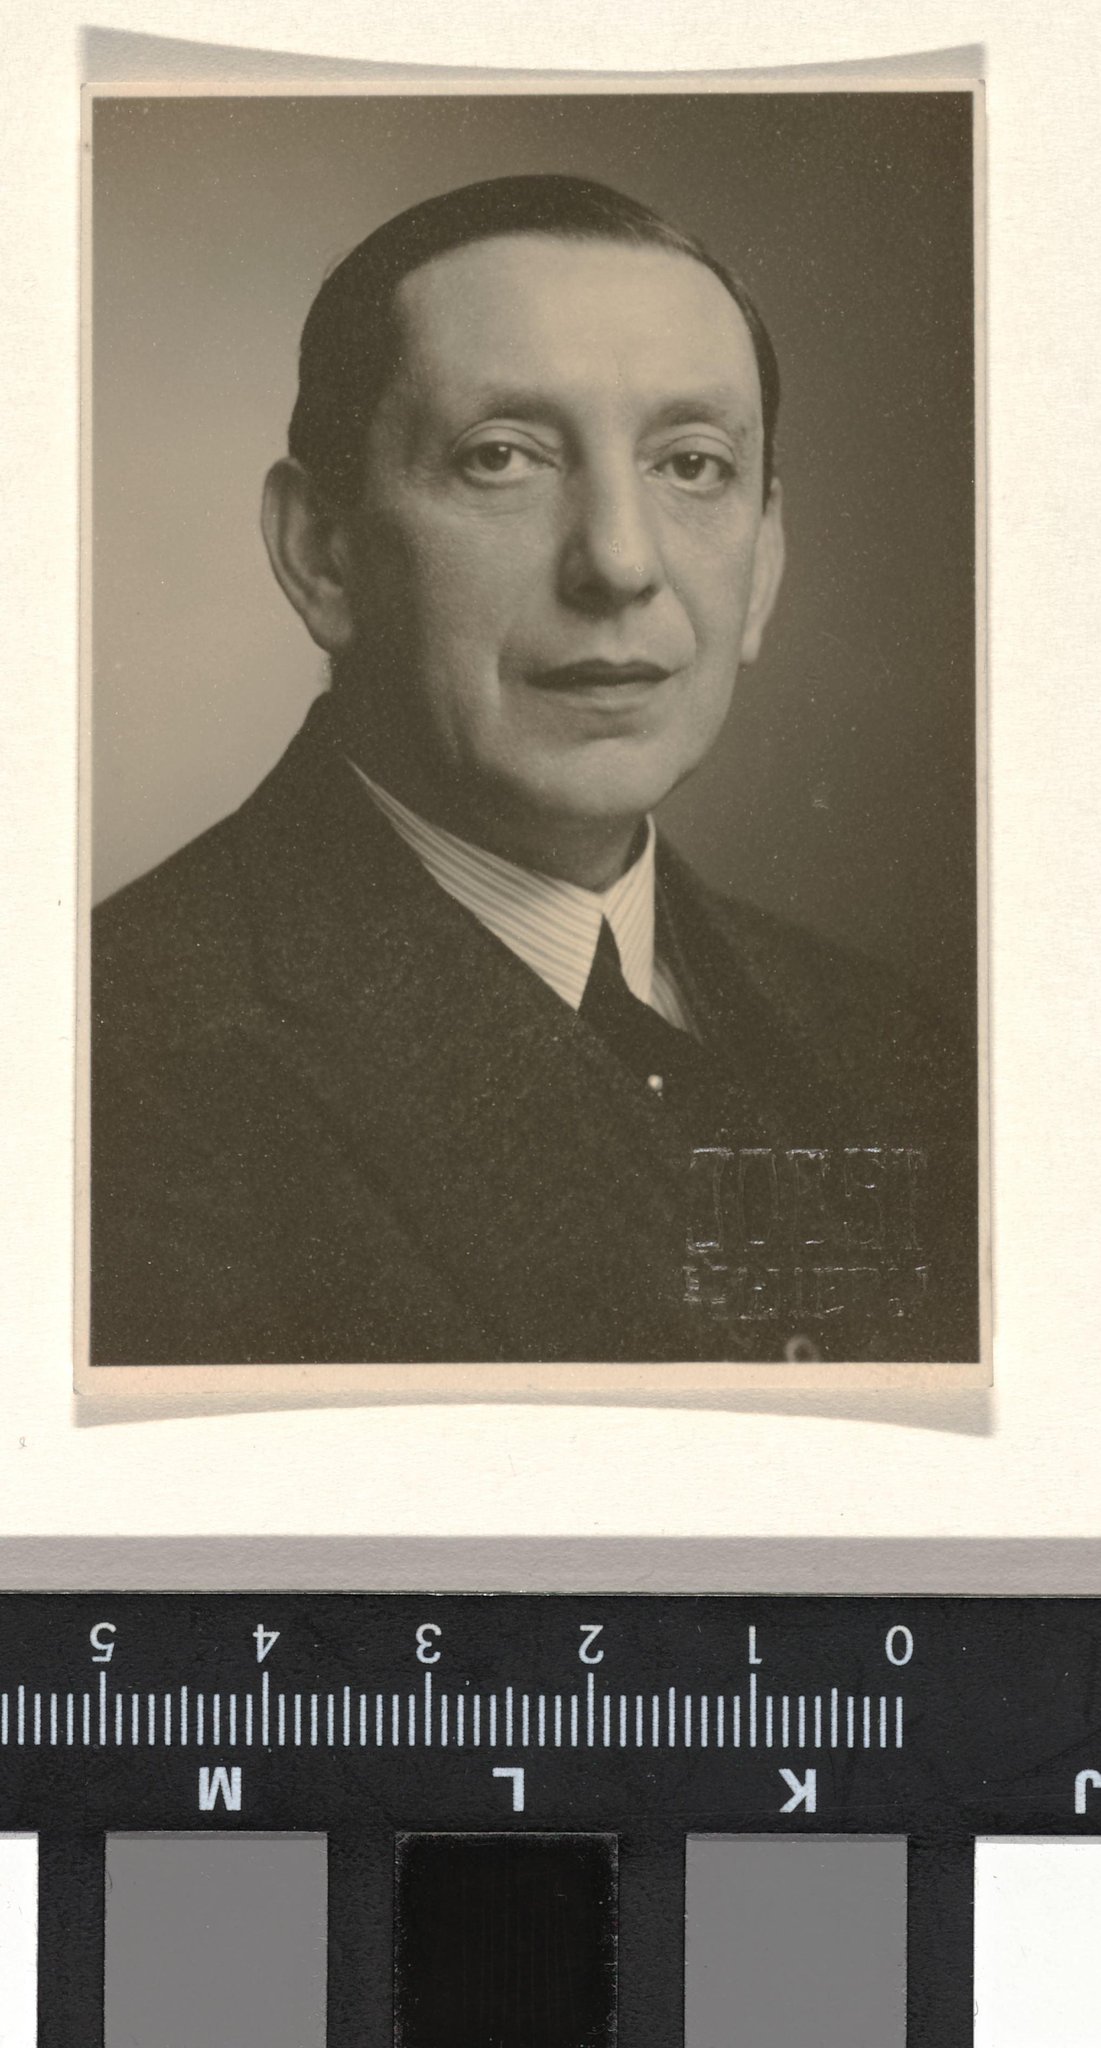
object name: photograph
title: Portret van een onbekende oom gekleed in donker kostuum met een gestreepte kraag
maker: Anonymous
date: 1920-1955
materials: photographic support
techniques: gelatin silver print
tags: vienna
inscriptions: inscription: ‘In treuen Freundschaft und treuen Anhänglichkeit dein Onkel ...’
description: Portret van een onbekende oom, gekleed in donker kostuum met een gestreepte kraag.